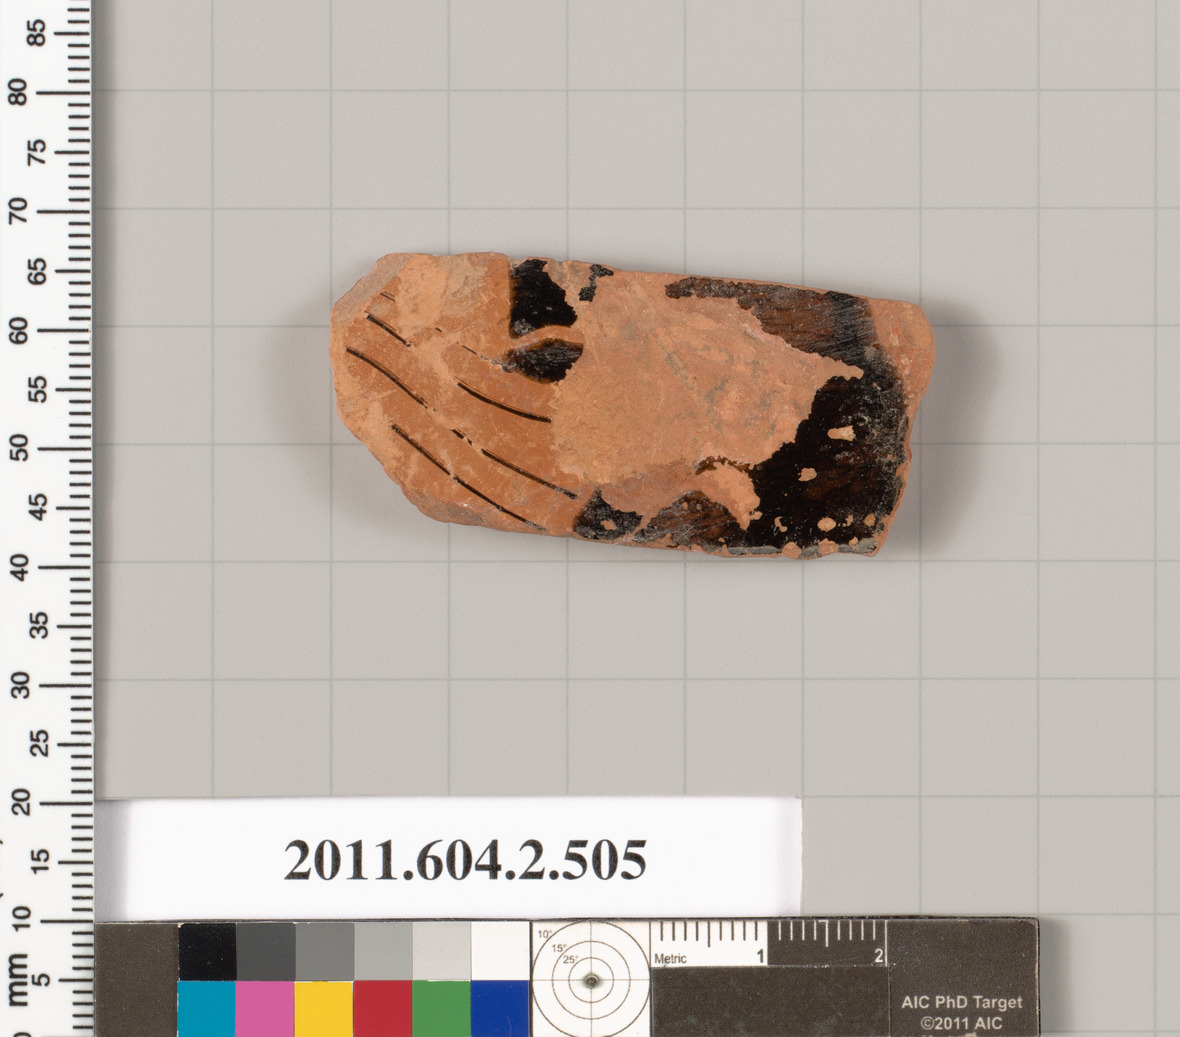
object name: column krater fragment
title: Terracotta fragment of a column-krater (bowl for mixing wine and water)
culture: greek, attic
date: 460-440 BCE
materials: terracotta